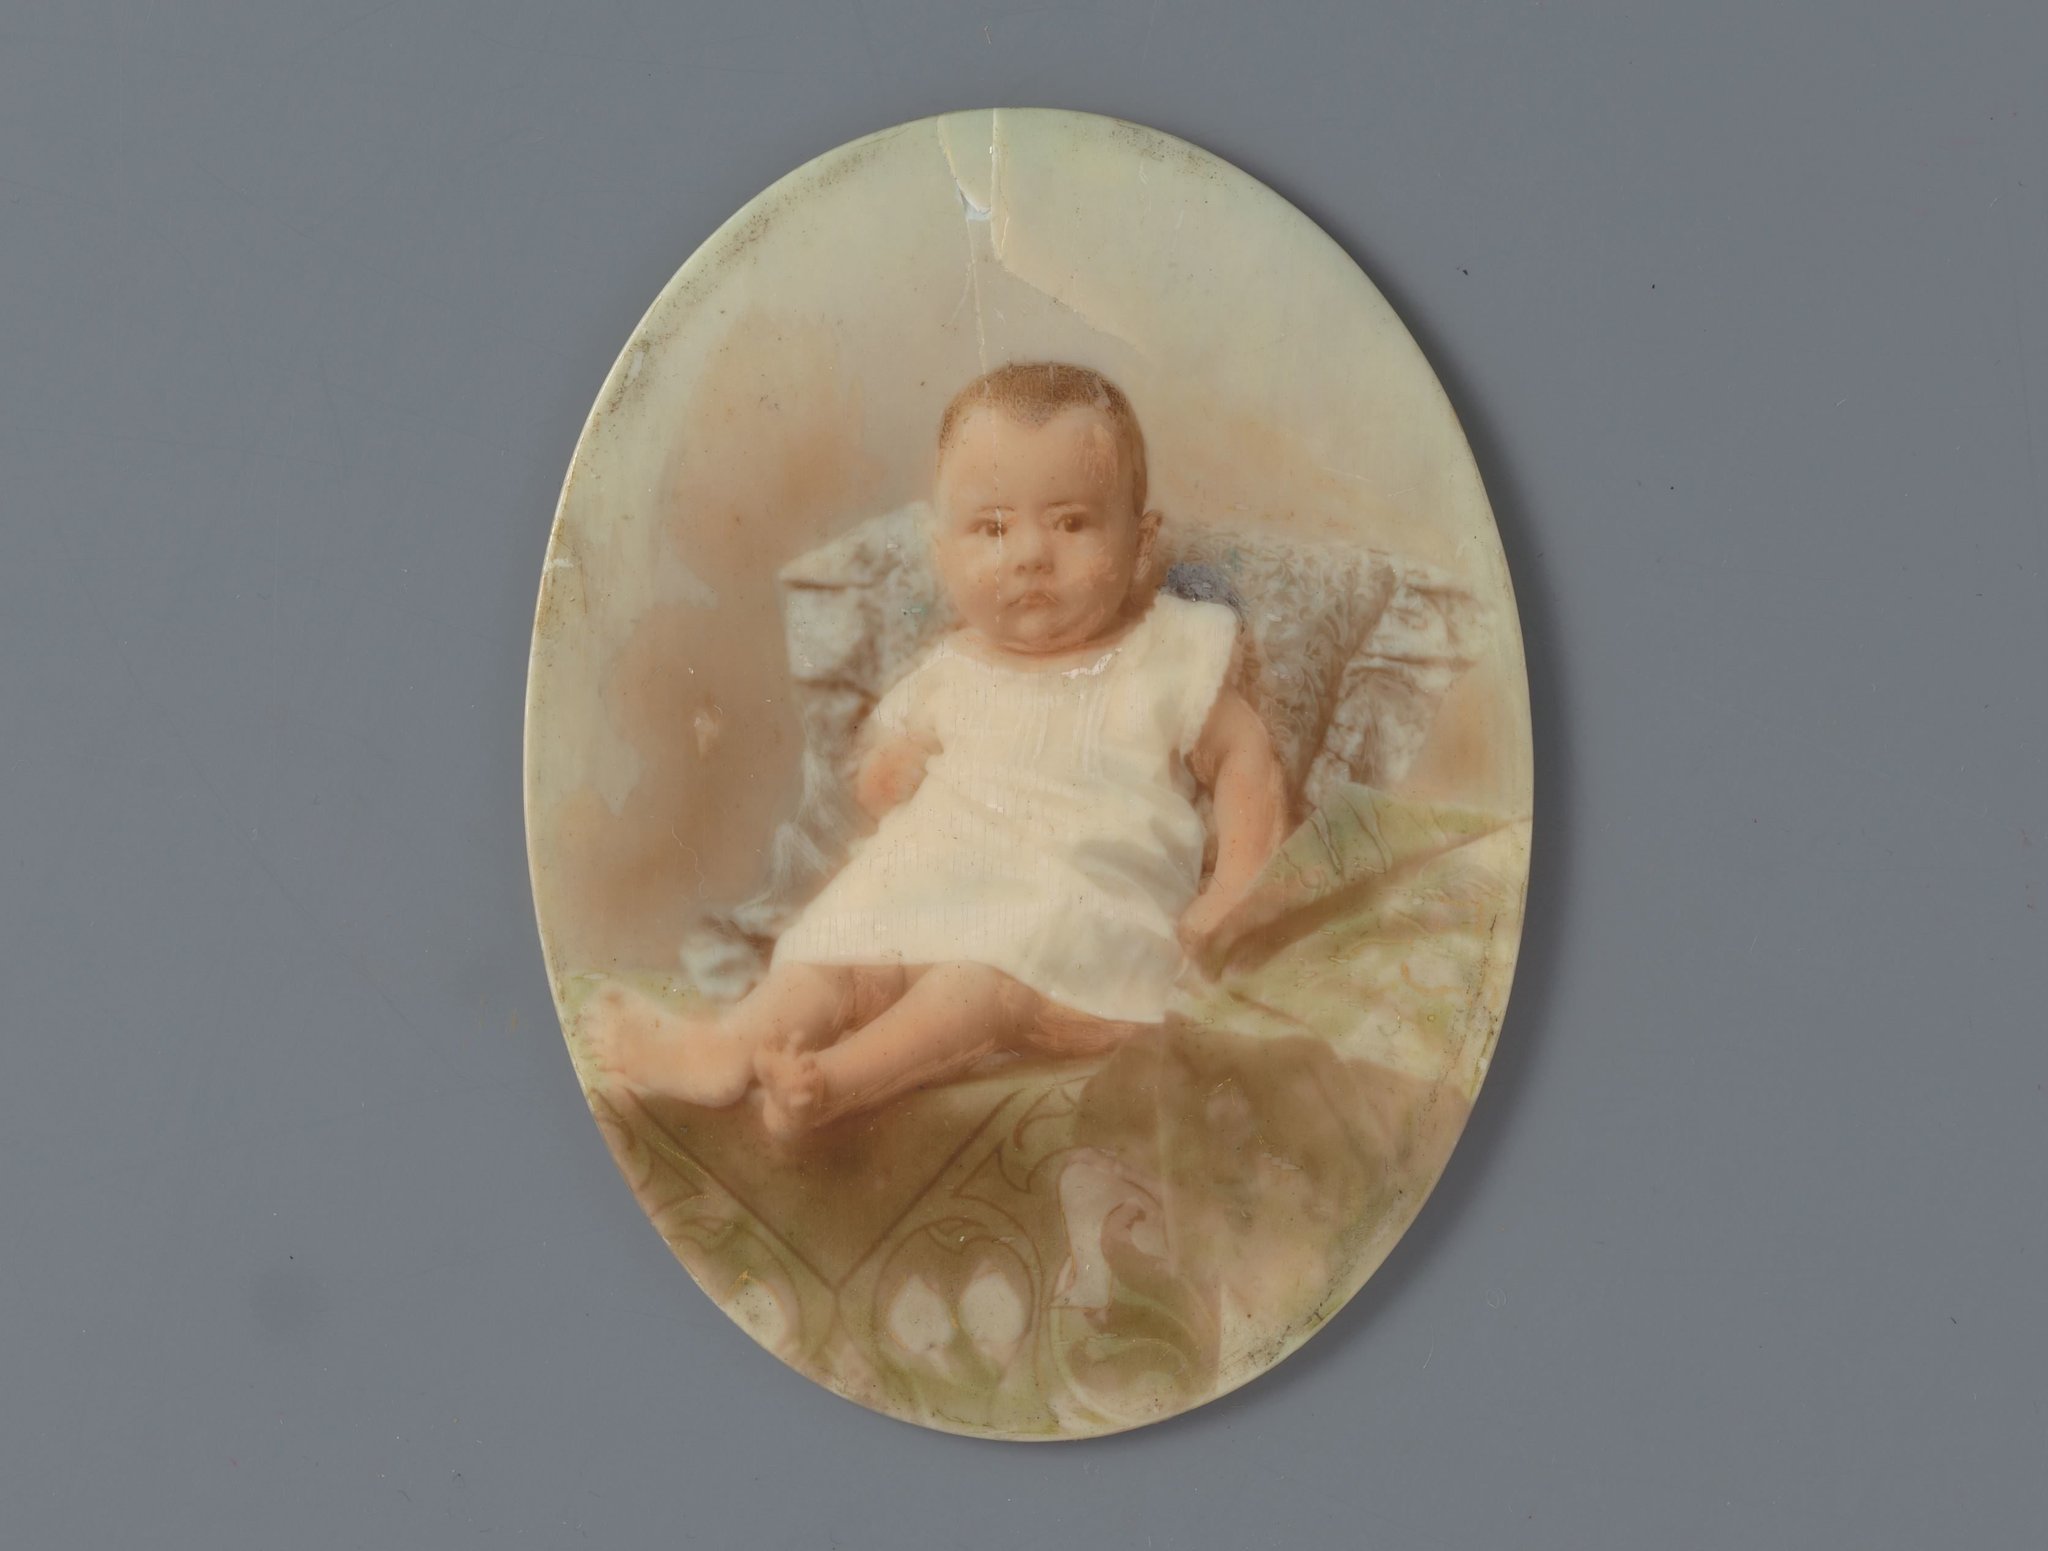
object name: photograph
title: Portret van een baby, zittend op een kleed met kussen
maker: Anonymous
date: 1900-1930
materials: ivory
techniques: hand coloring, photography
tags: infant, baby